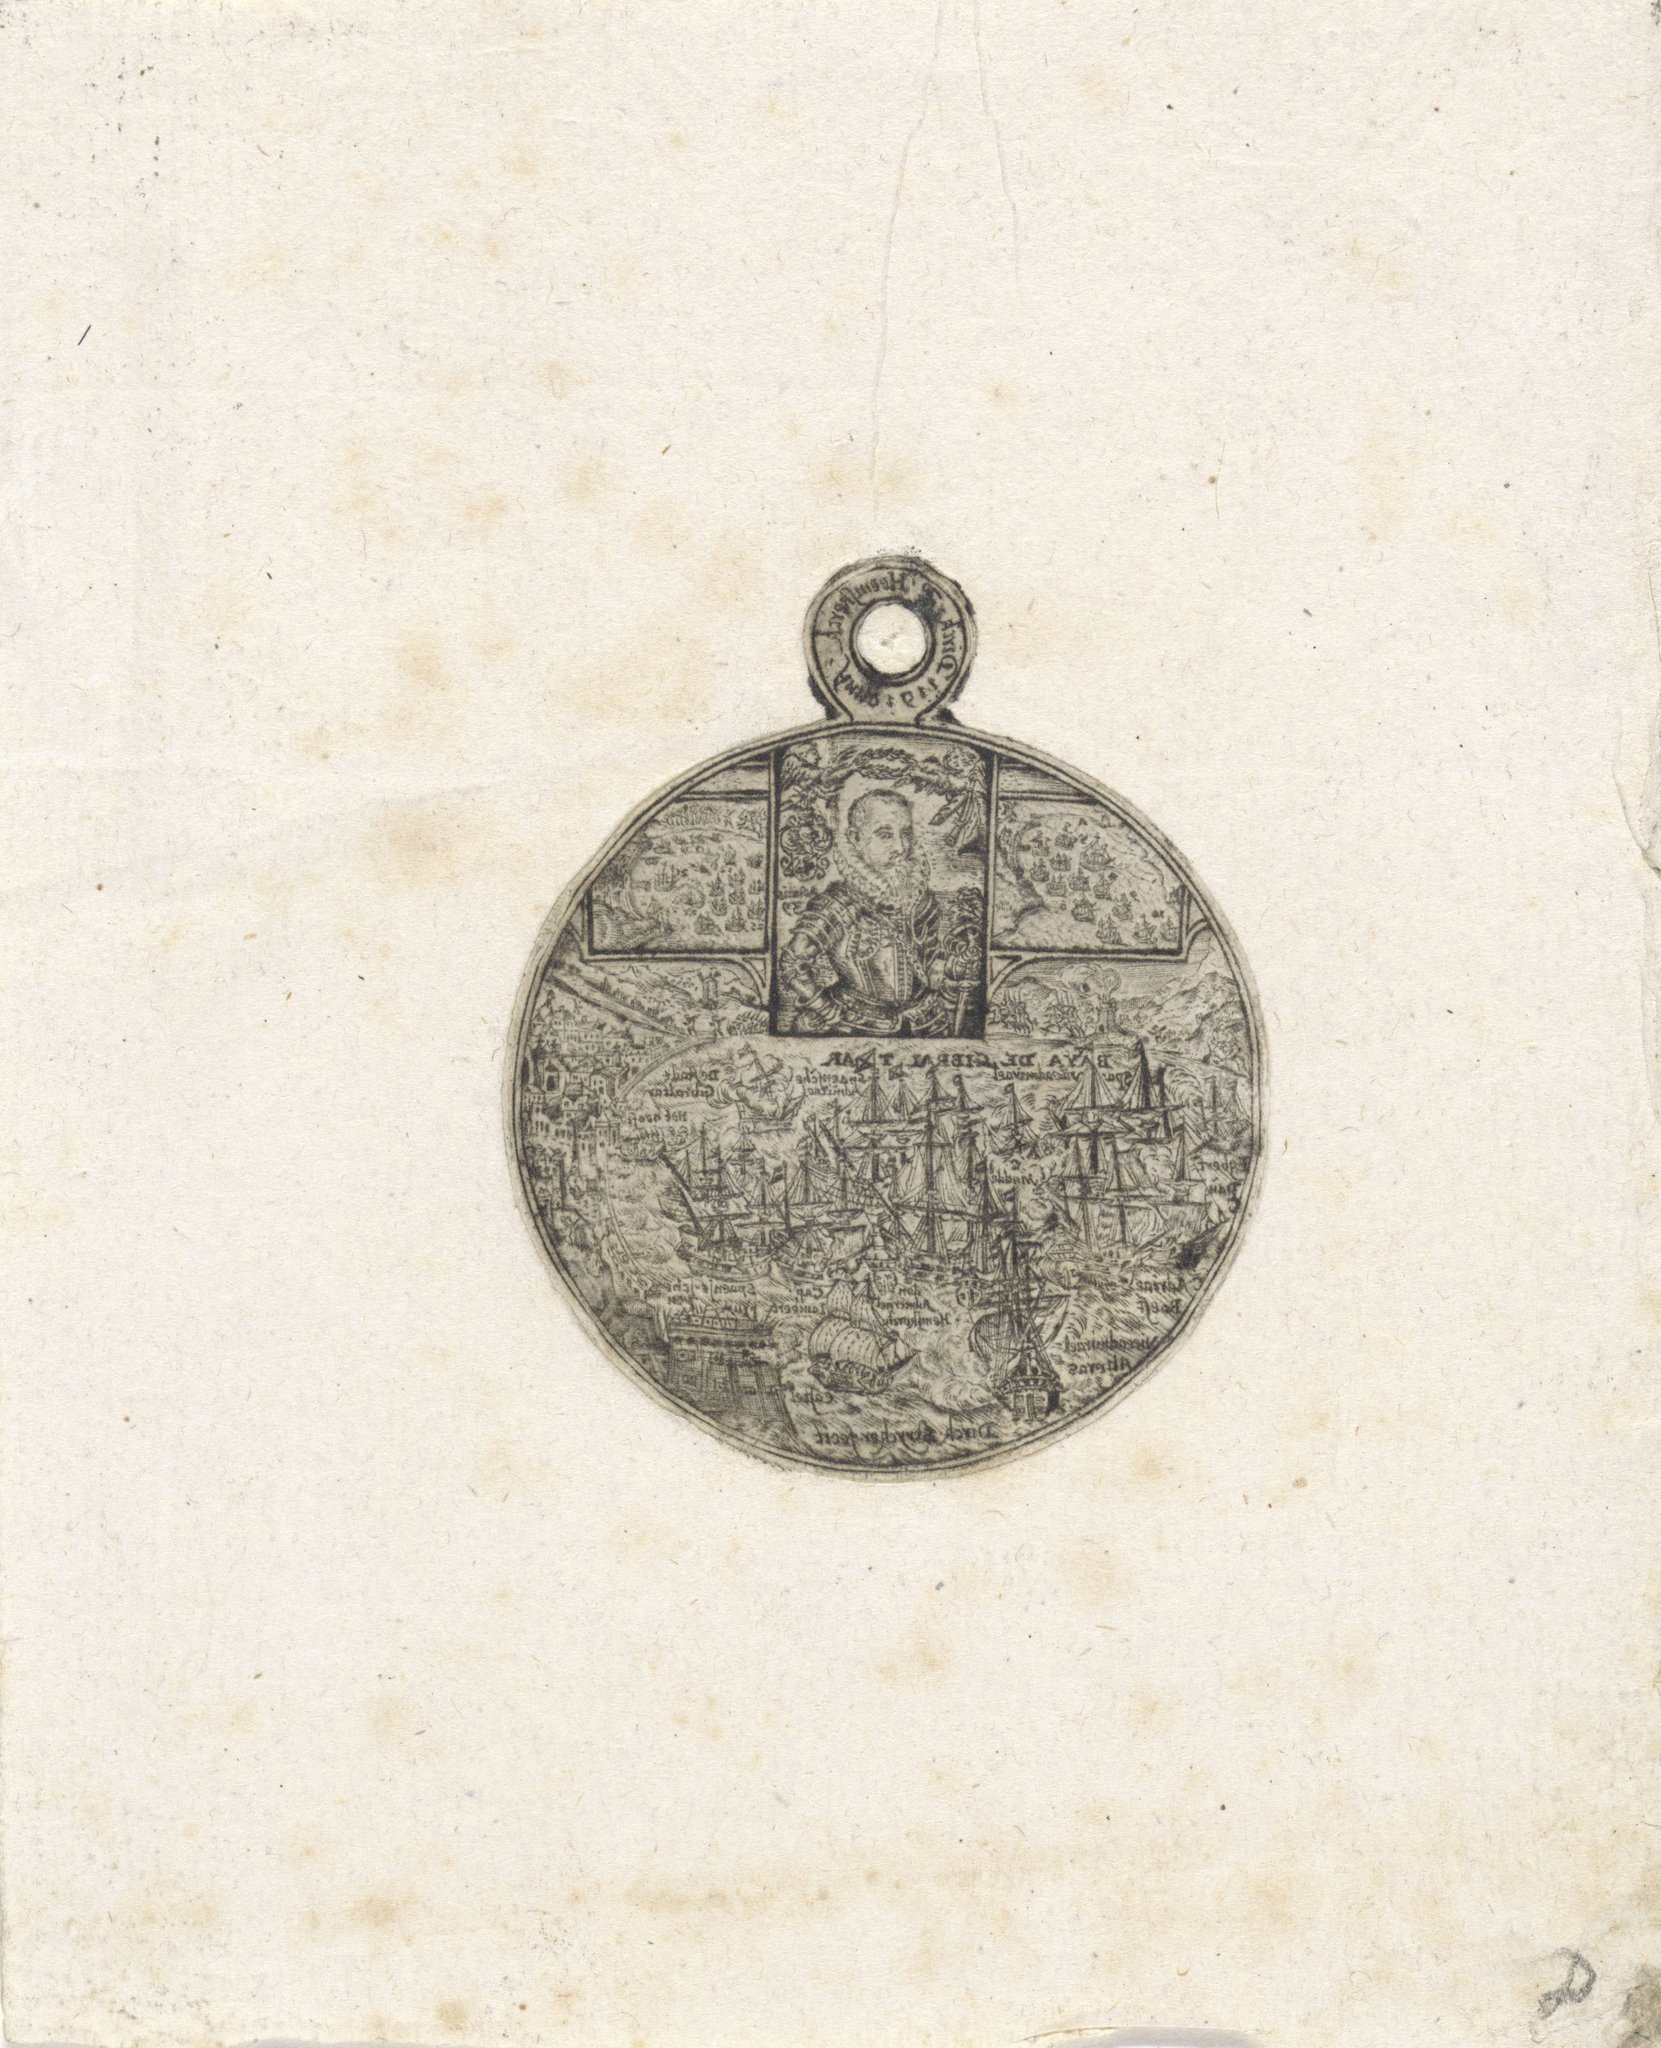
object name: print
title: Afdruk van de voorzijde van een gegraveerde penning met het portret en de dood van Jacob van Heemskerck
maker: dirck strijcker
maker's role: draughtsman, print maker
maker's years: 1588-1677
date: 1611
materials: paper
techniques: engraving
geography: amsterdam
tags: jacob van heemskerck, historical persons, battle (+ sailing-ships)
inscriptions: collector's mark: Lugt 2228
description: Midden boven het portret van Jacob van Heemskerck. Onder: de zeeslag bij Gibraltar in 1607 waarbij van Heemskerck sneuvelde.